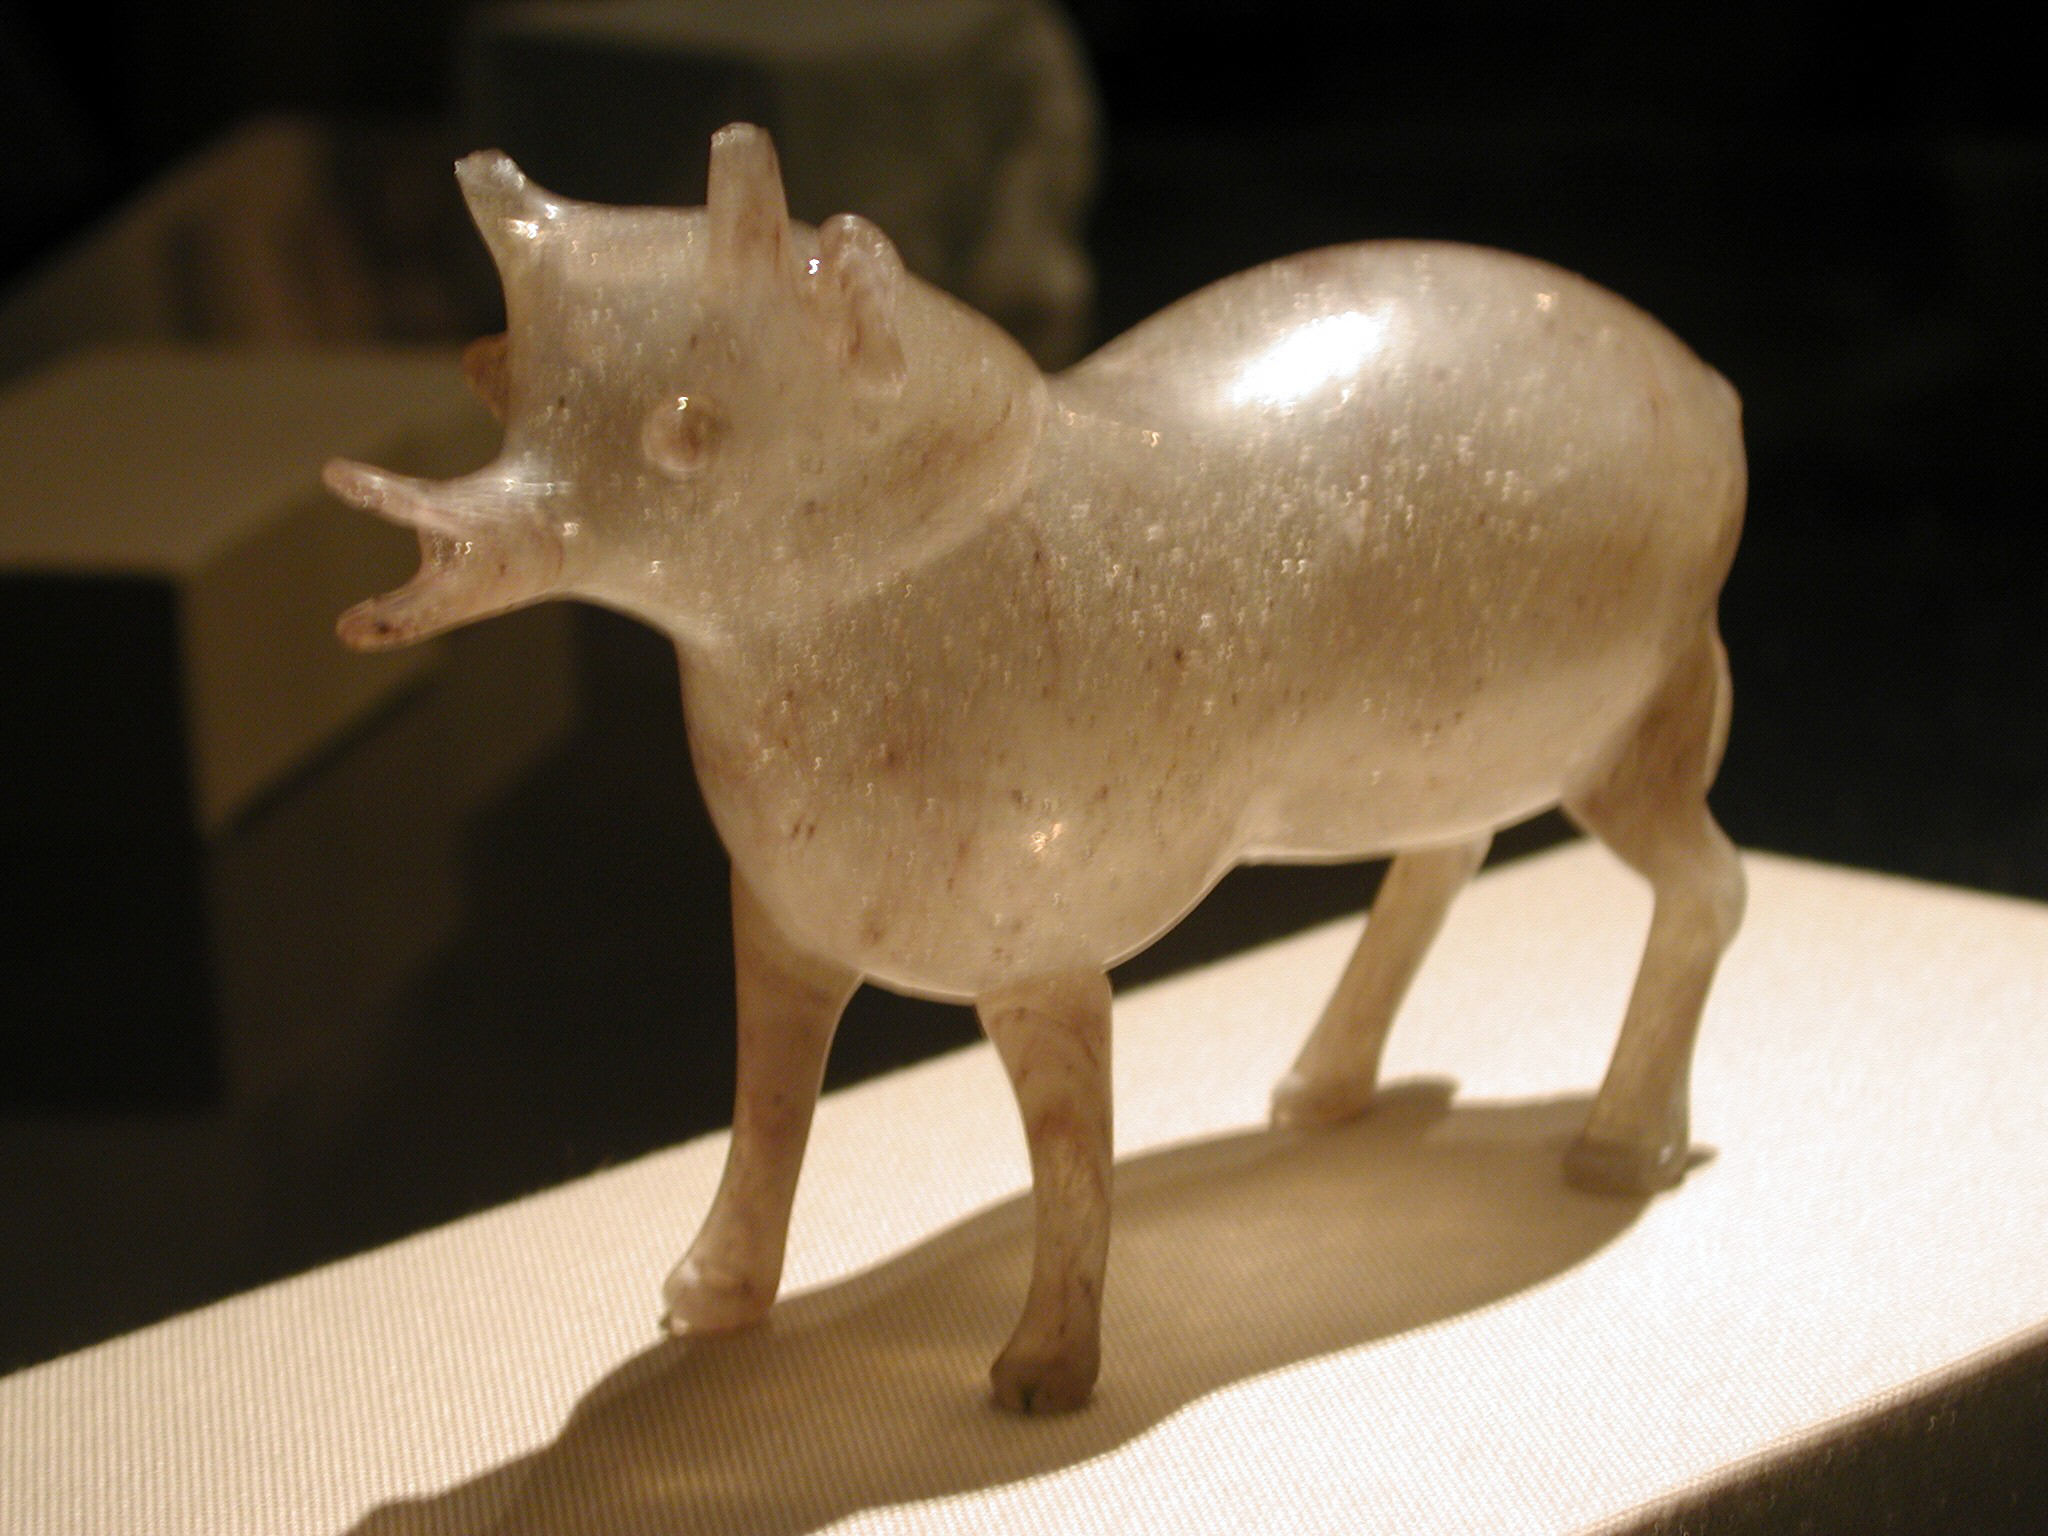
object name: figure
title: Ram (?)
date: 1601-1800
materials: glass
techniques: glassblowing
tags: animals